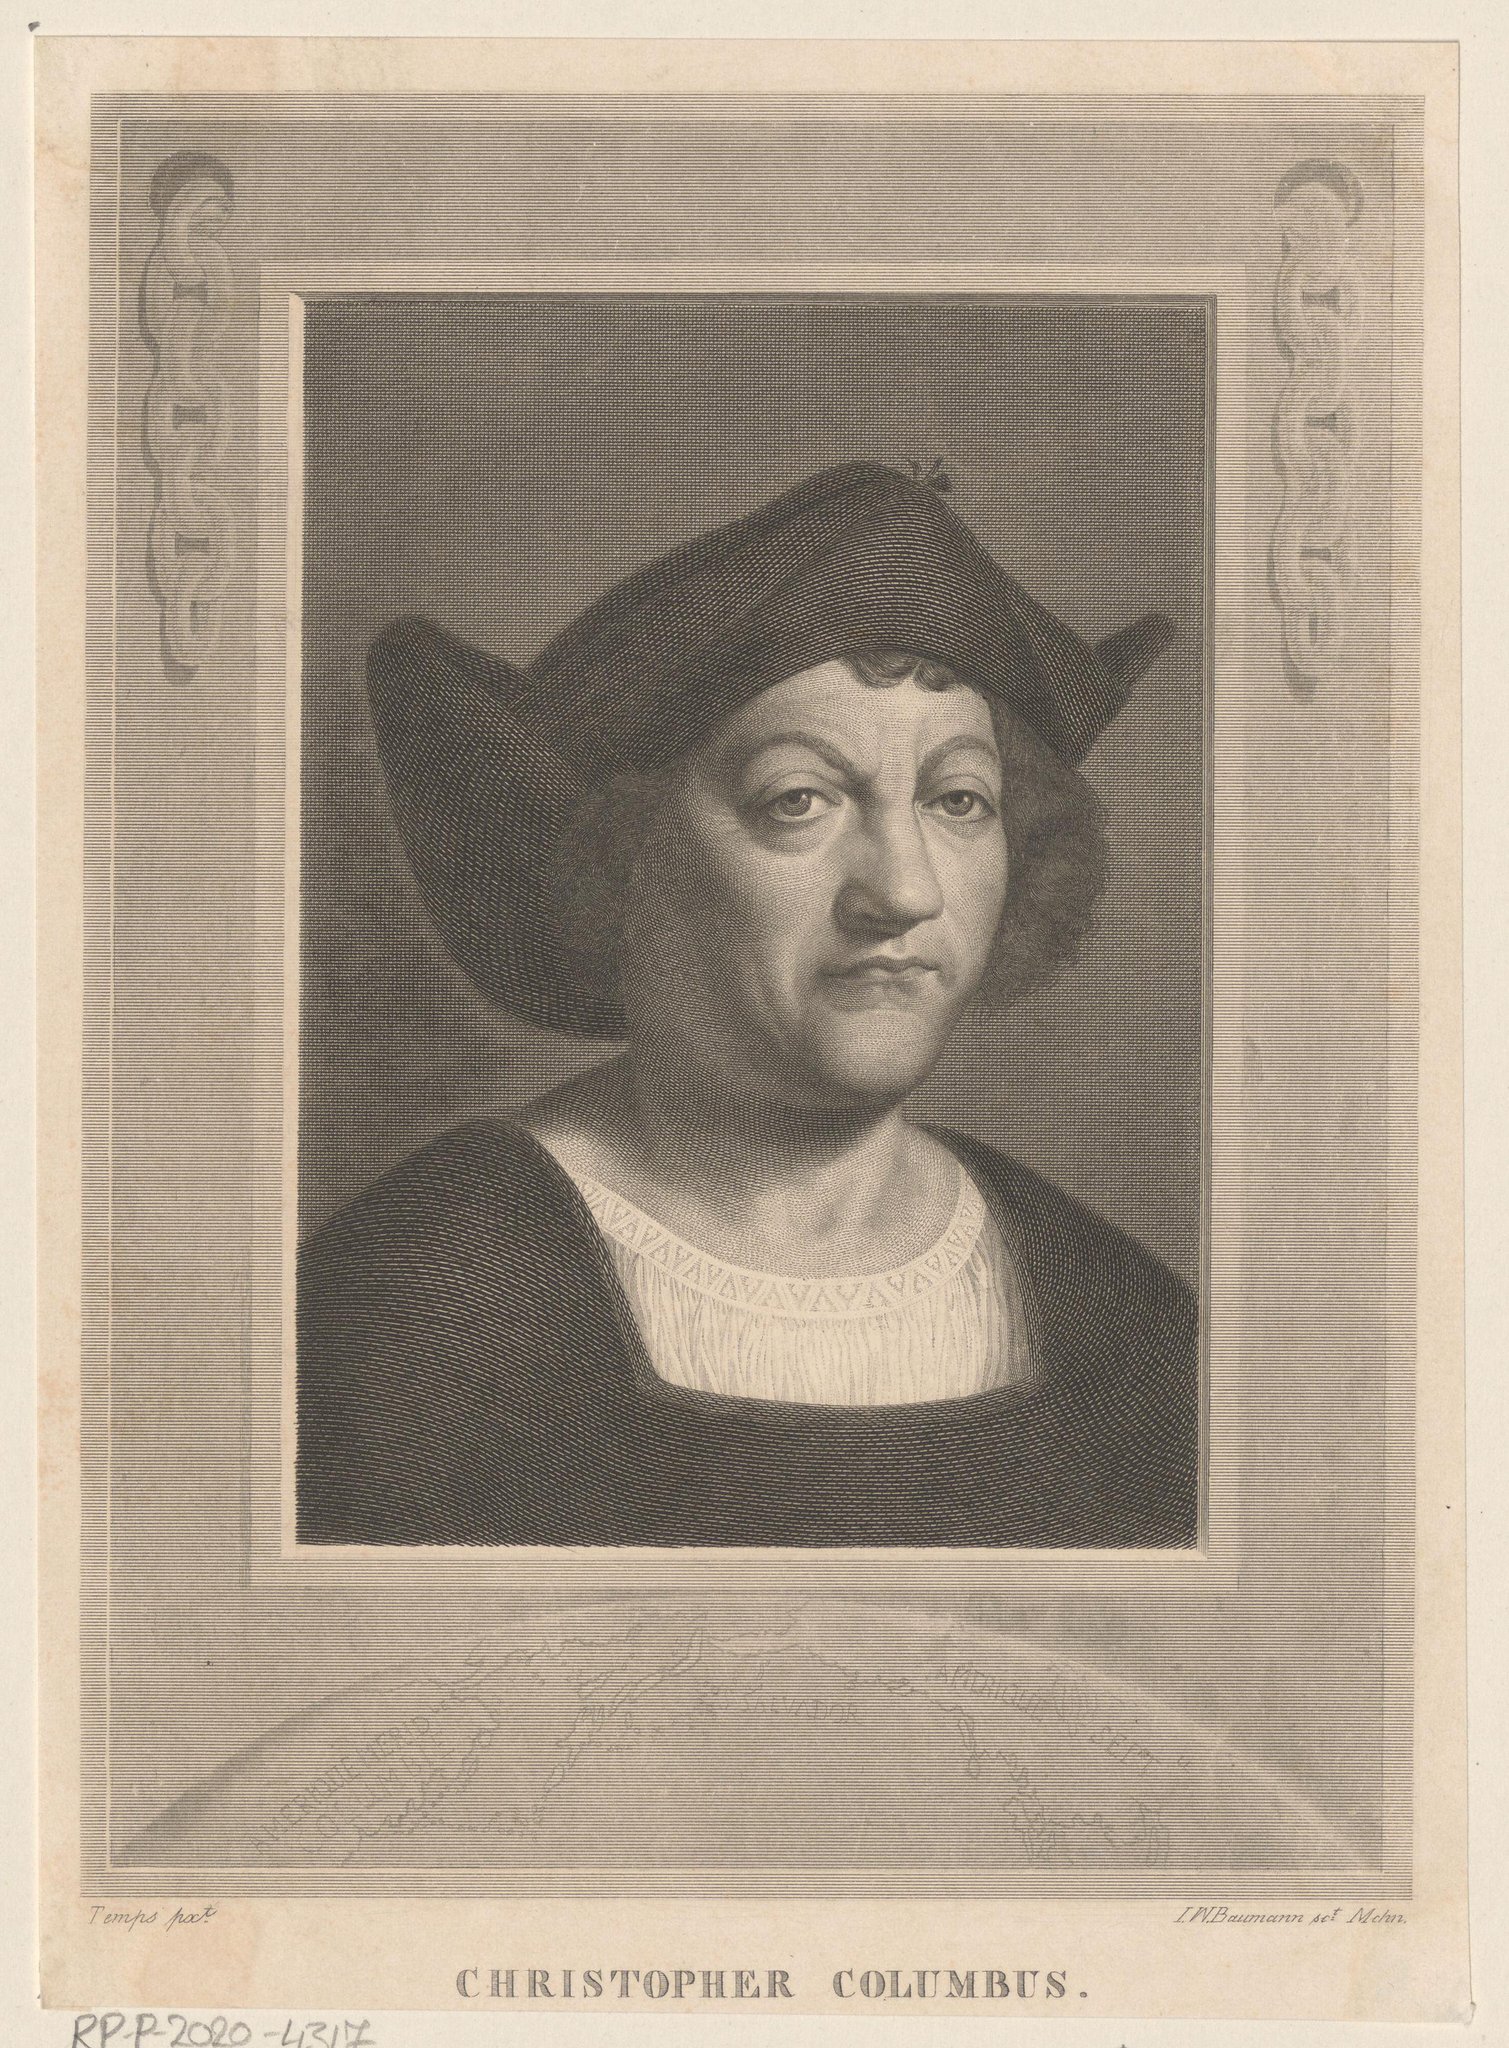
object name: print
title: Portret van Christoffel Columbus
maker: johann wilhelm baumann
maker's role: print maker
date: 1800-1899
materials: paper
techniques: engraving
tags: historical persons